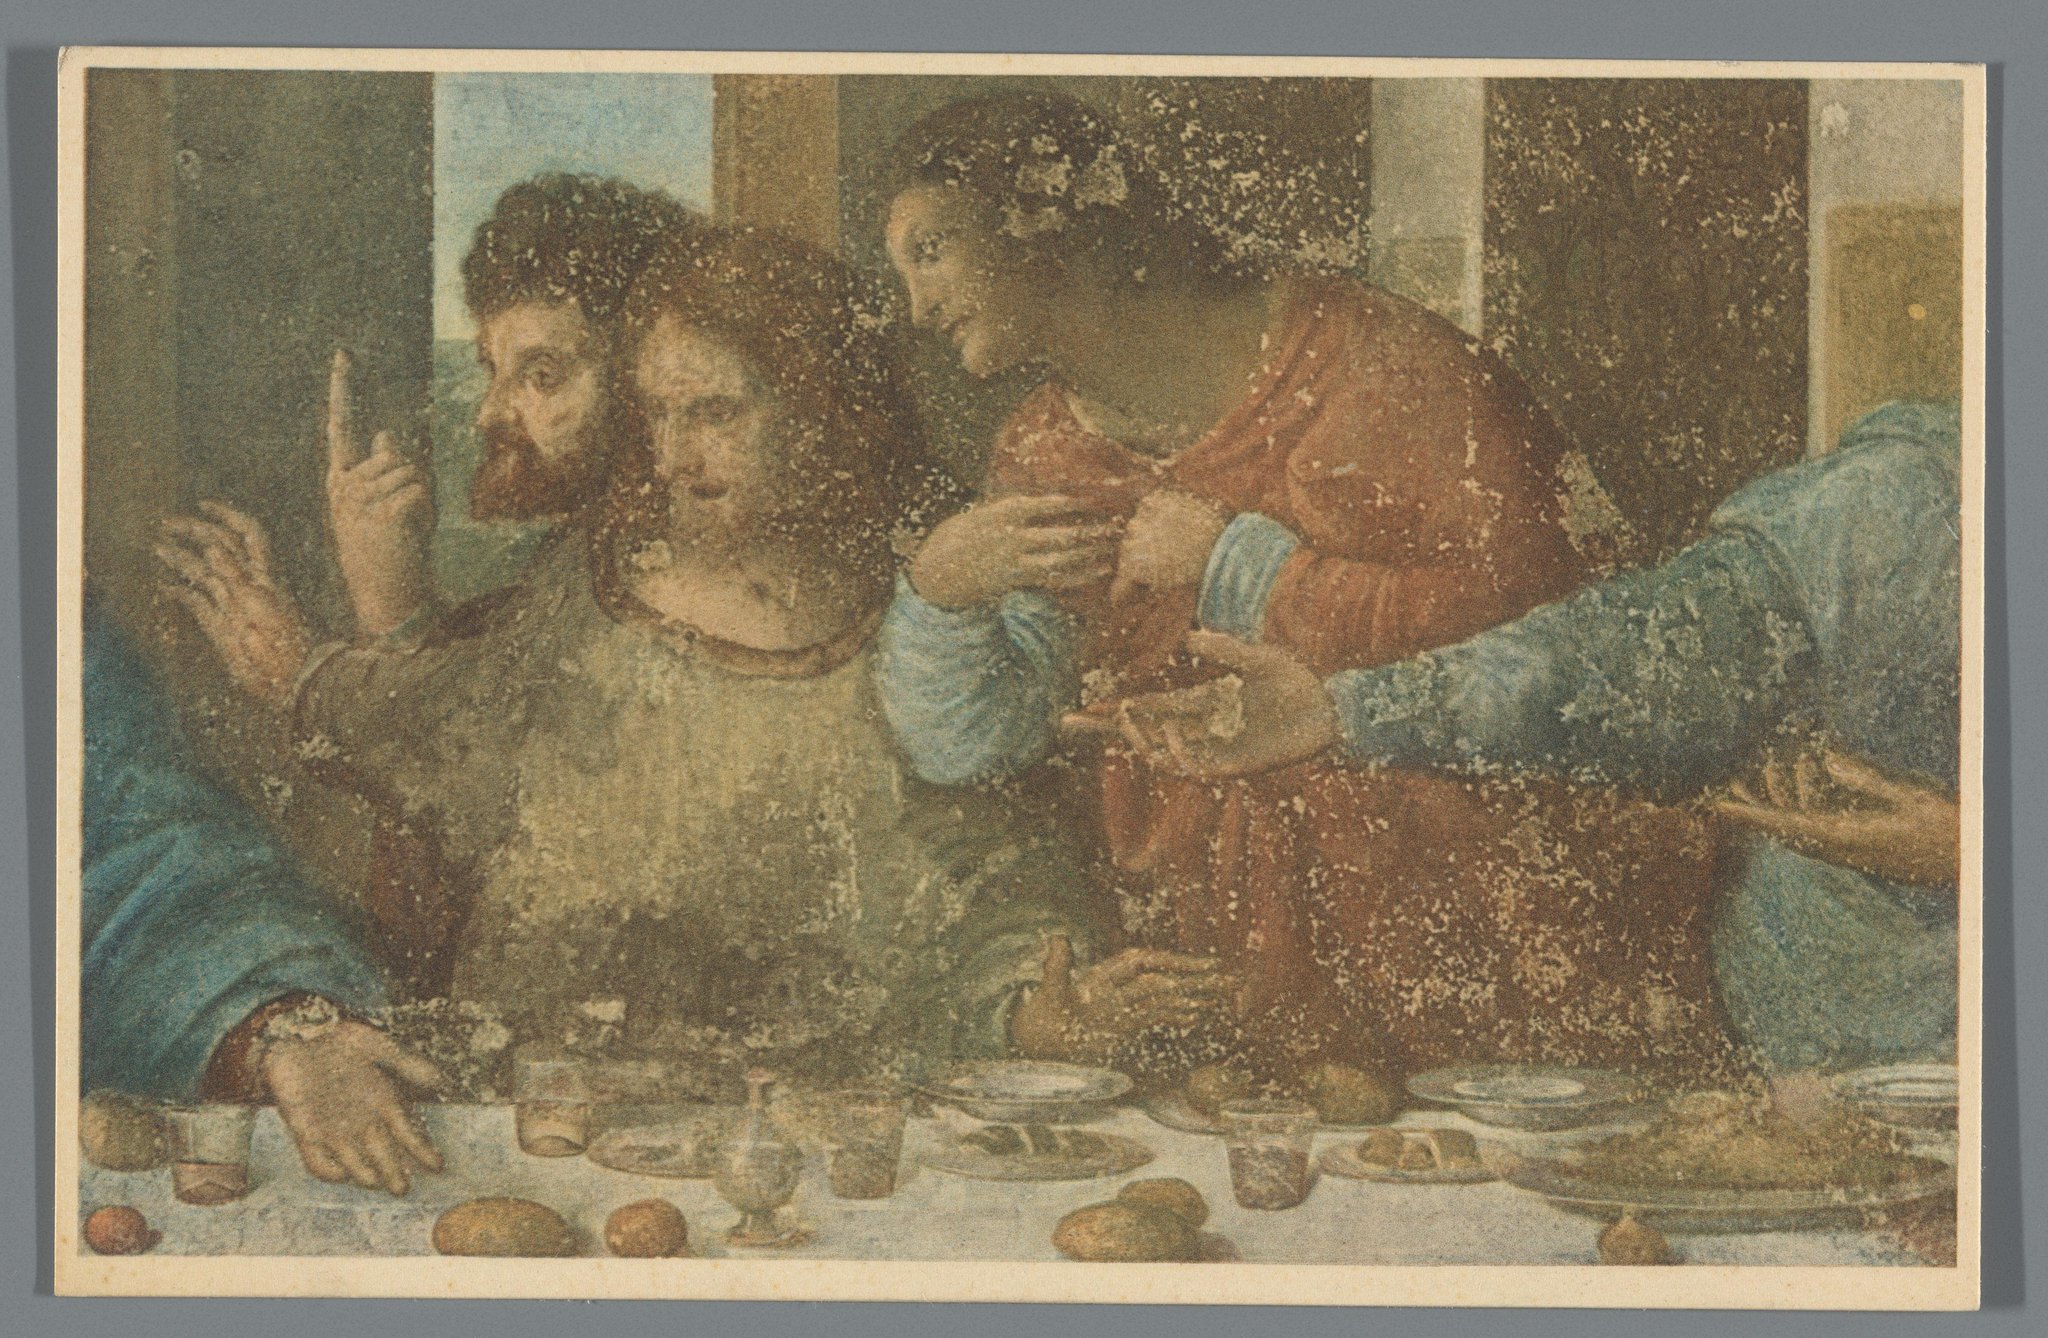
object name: photomechanical print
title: Ultima Cena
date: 1900-1930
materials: paper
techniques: photograph, lithograph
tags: the episode of the last supper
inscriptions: number: ‘N. 71’, inscription: ‘R.R. GALLERIE E MONOMENTI DI LOMBARDIA/ MILANO’